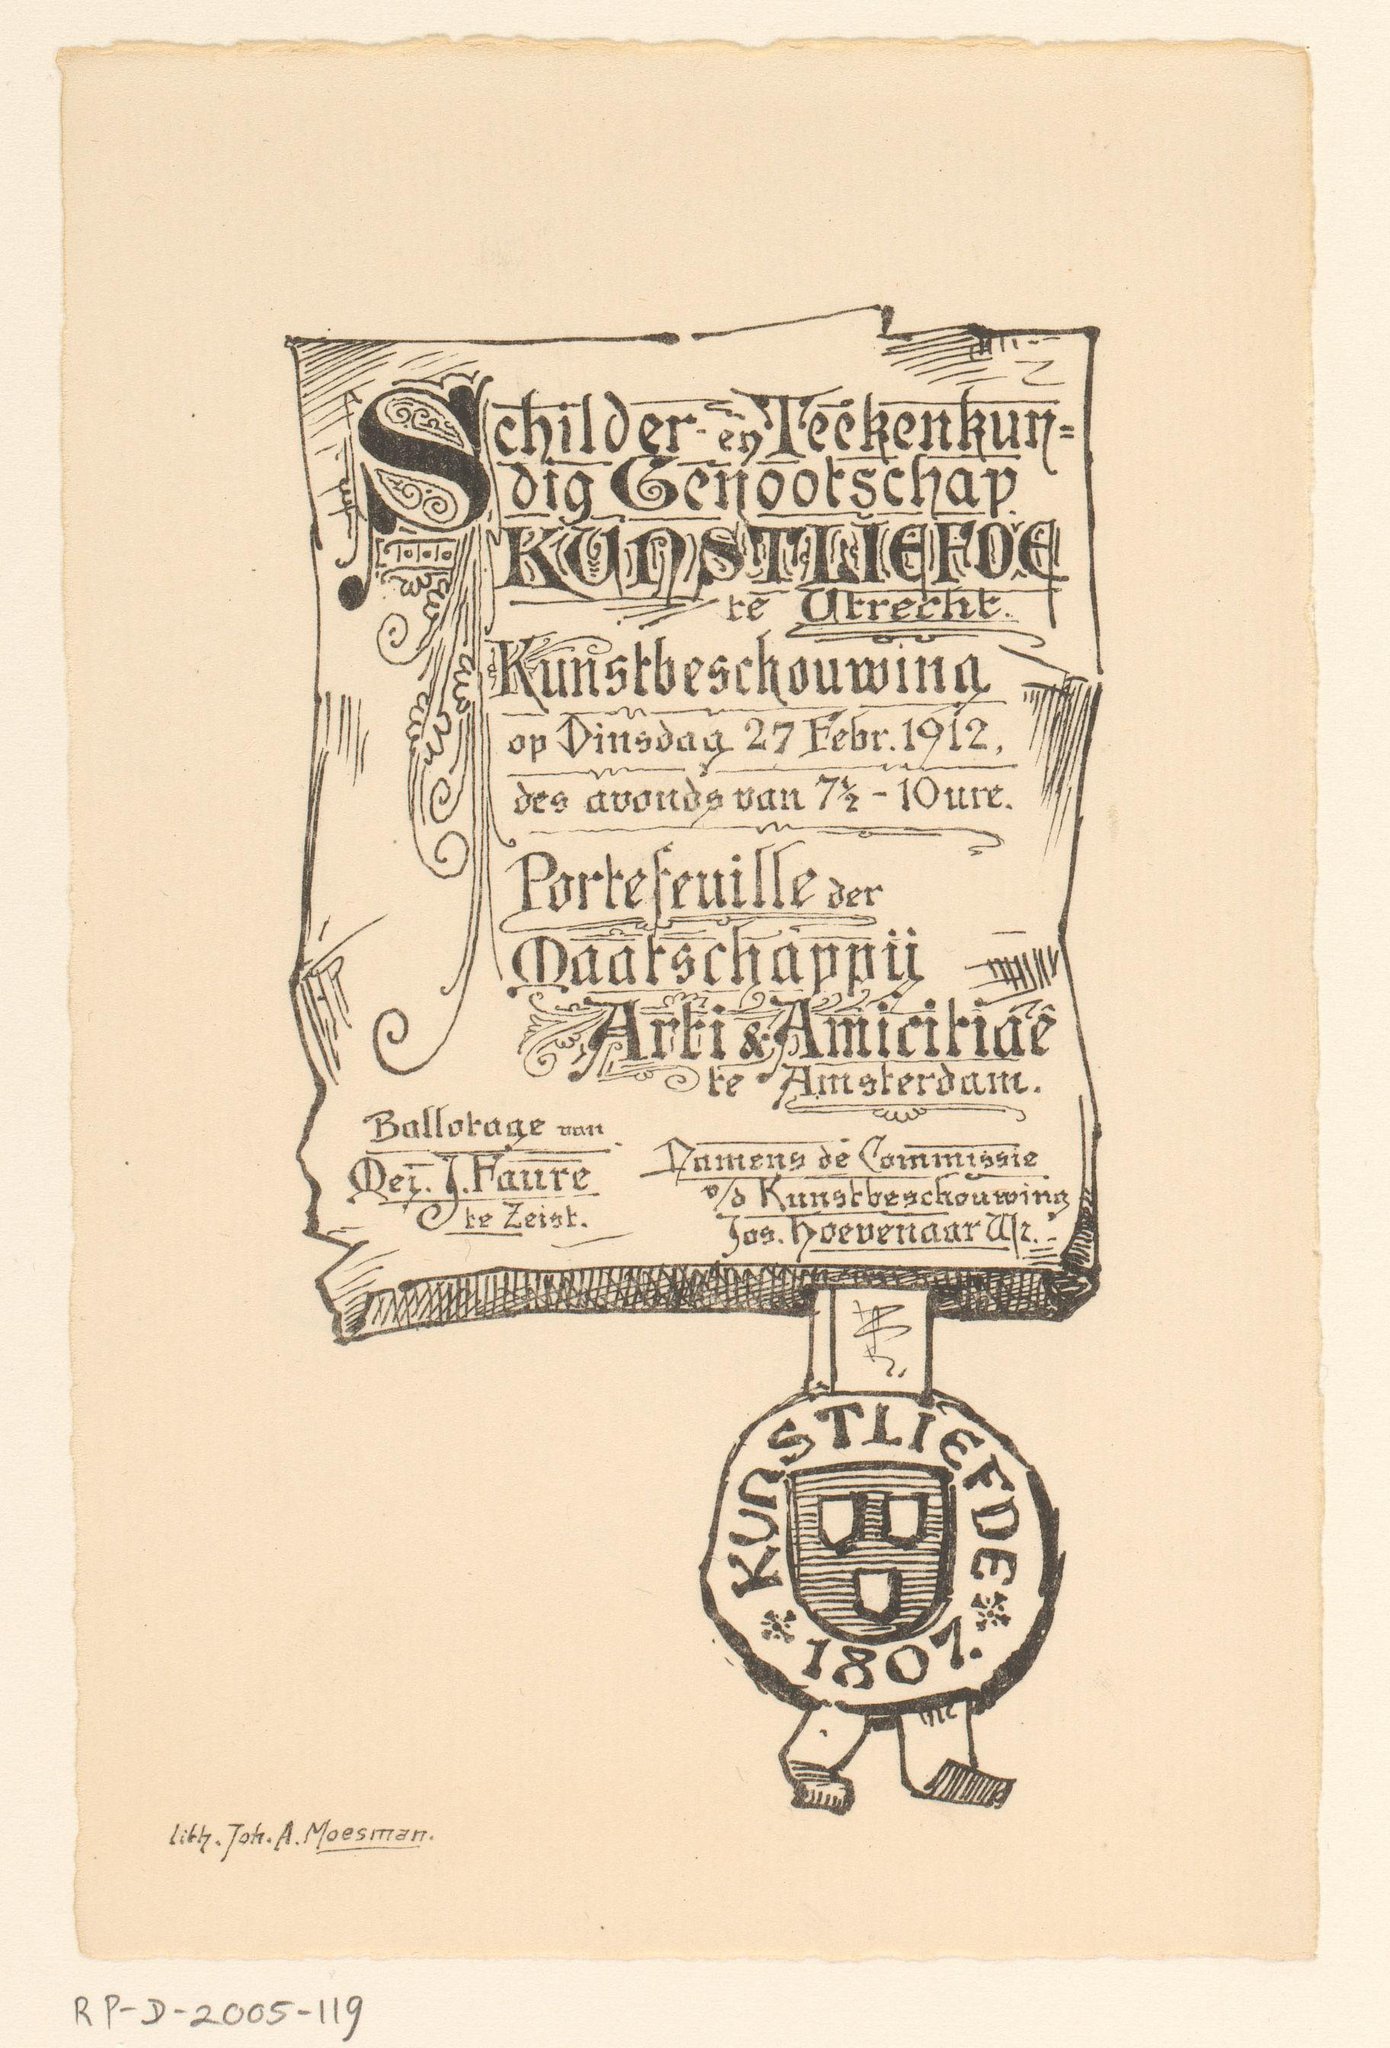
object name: print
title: Uitnodiging van Schilder- en Teekenkundig Genootschap "Kunstliefde" voor een kunstbeschouwing, 27 februari 1912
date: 1902-1912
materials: paper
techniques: lithograph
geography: utrecht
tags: criticizing and discussing art, art criticism, circle, club of artists, collecting and exhibiting products of the fine arts, seal, stamp, handwriting, written text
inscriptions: collector's mark: Lugt 2228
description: Charter met lakzegel. Uitnodiging van Schilder- en Teekenkundig Genootschap "Kunstliefde" voor een kunstbeschouwing op 27 februari 1912 van de portefeuille van Arti et Amicitiae, te Amsterdam.